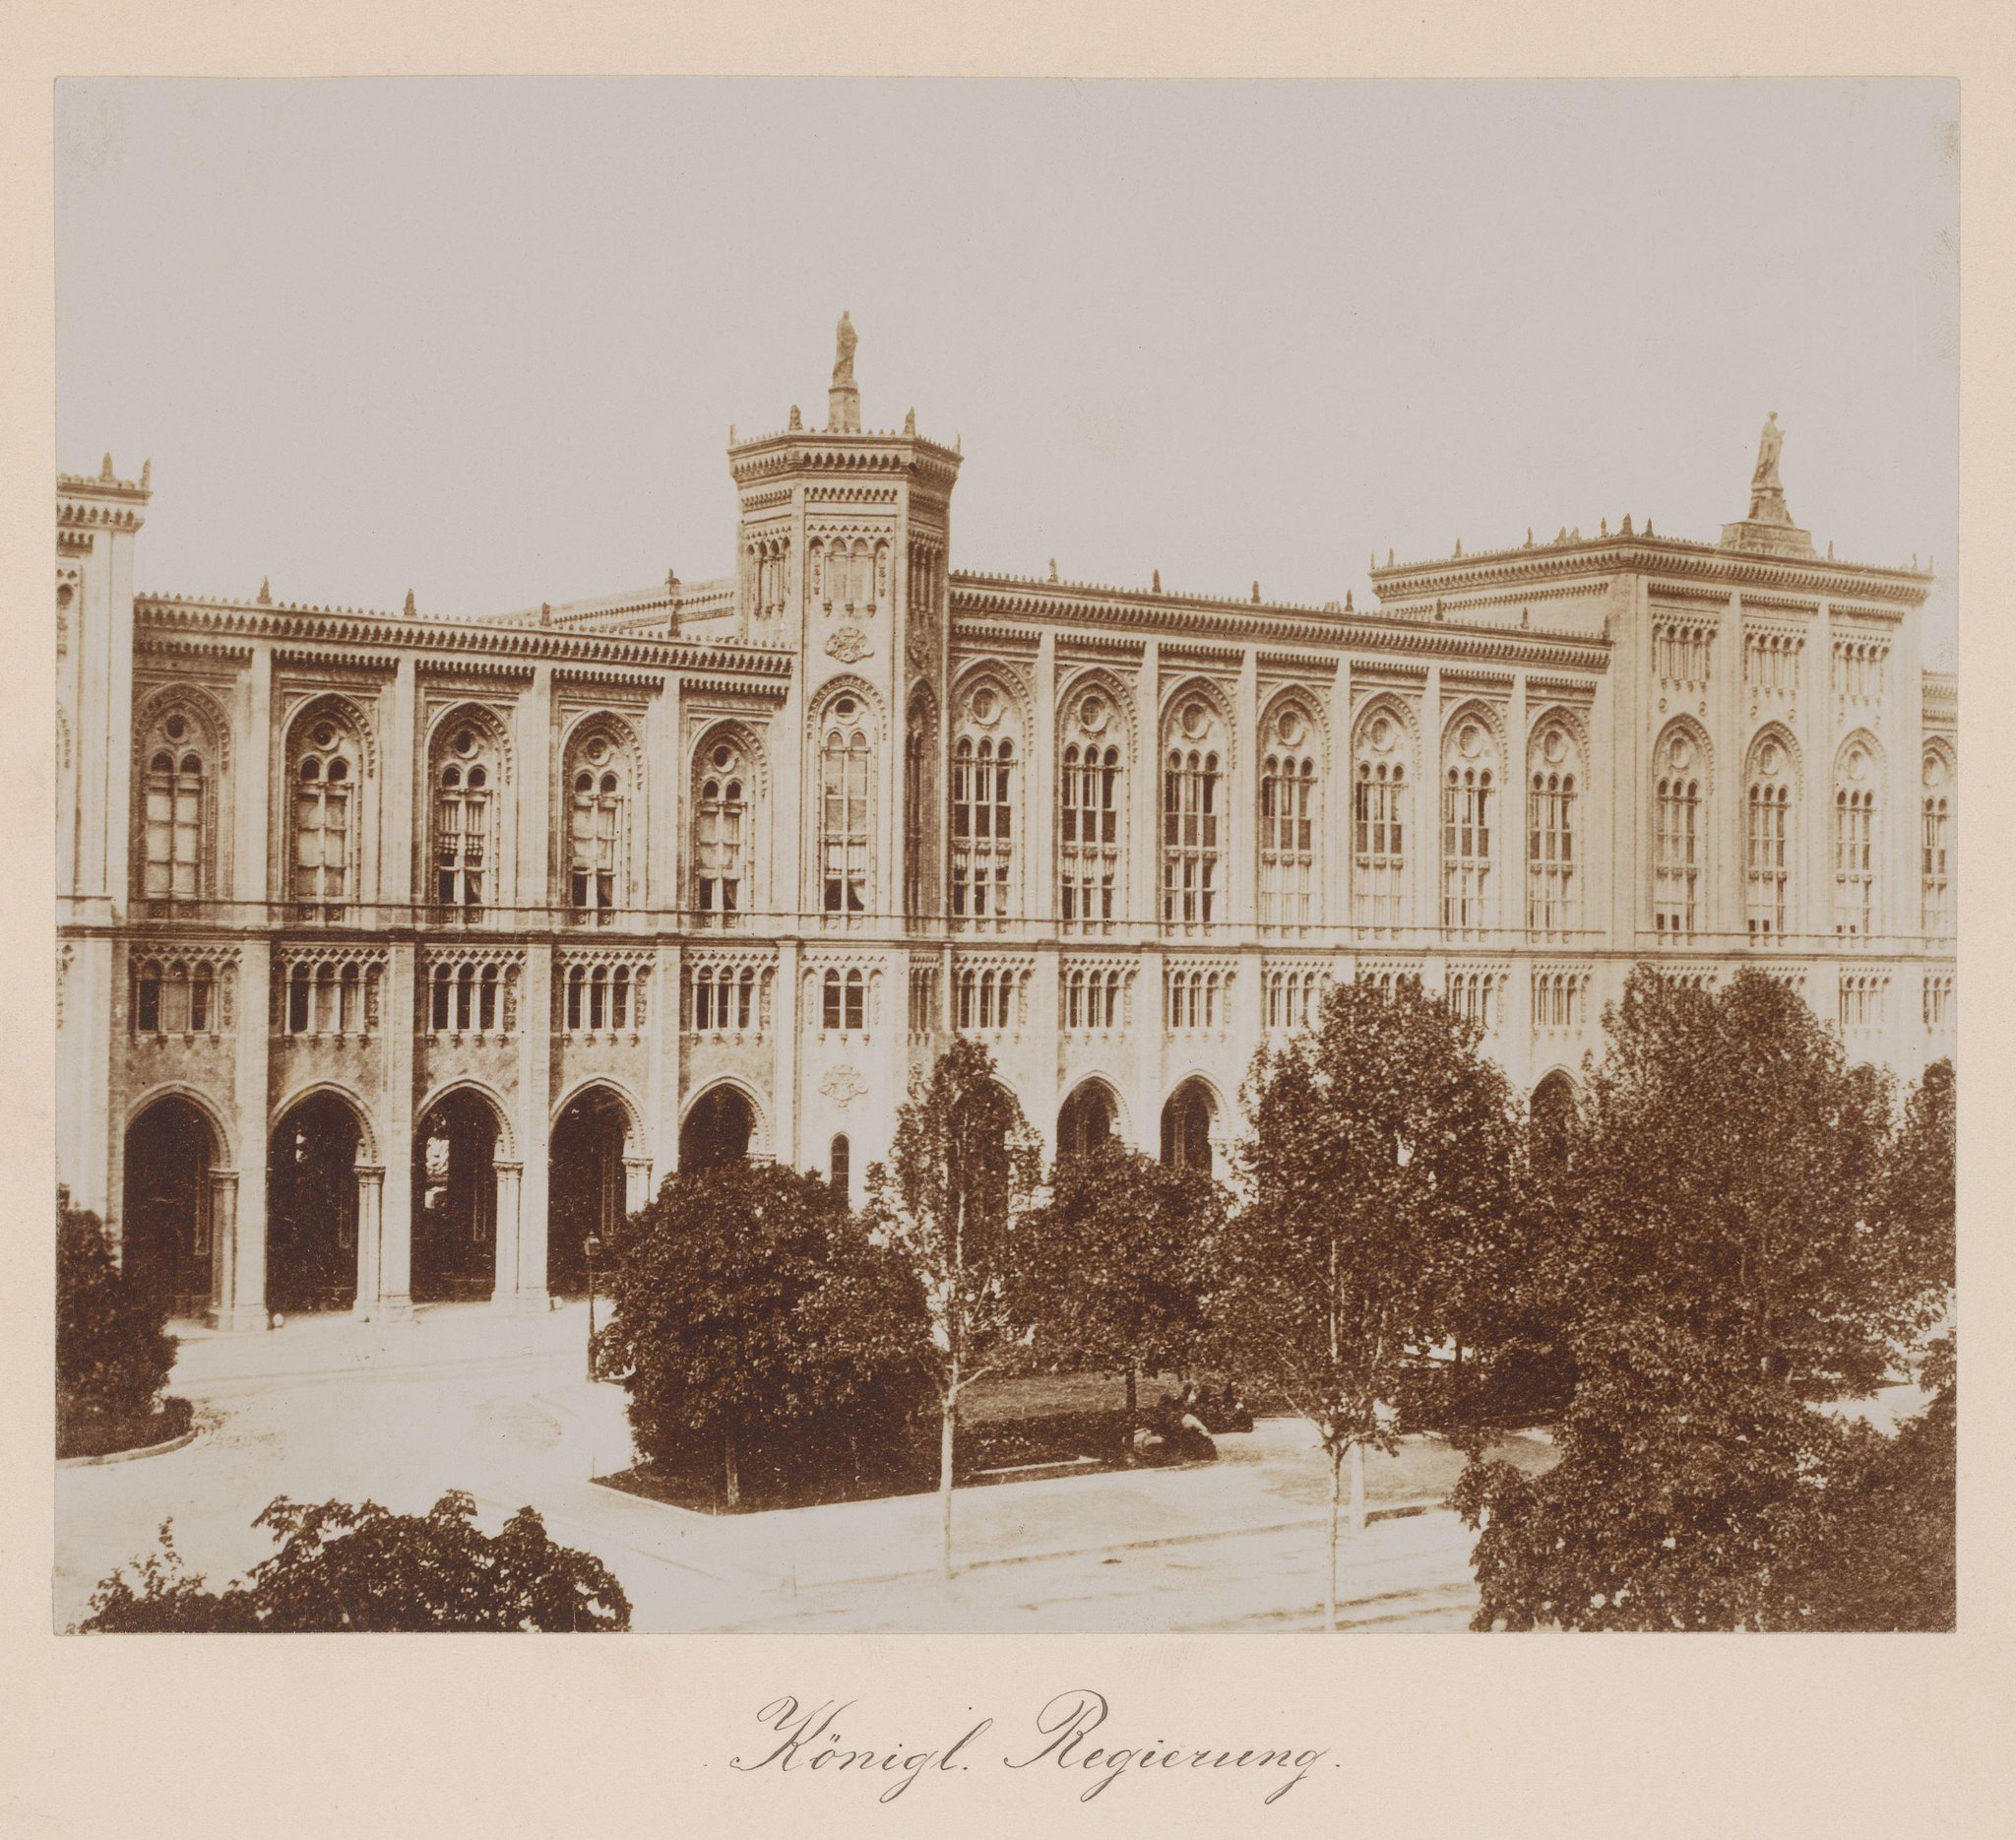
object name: photograph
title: Königliche Regierung, München, Duitsland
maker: Anonymous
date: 1880-1910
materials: cardboard, photographic support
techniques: collodion silver print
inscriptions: inscription: ‘Königl. Regierung.’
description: Aanzicht op een nog niet geïdentificeerd gebouw in München, in de koninklijke historiserende 'Rundbogenstil'.